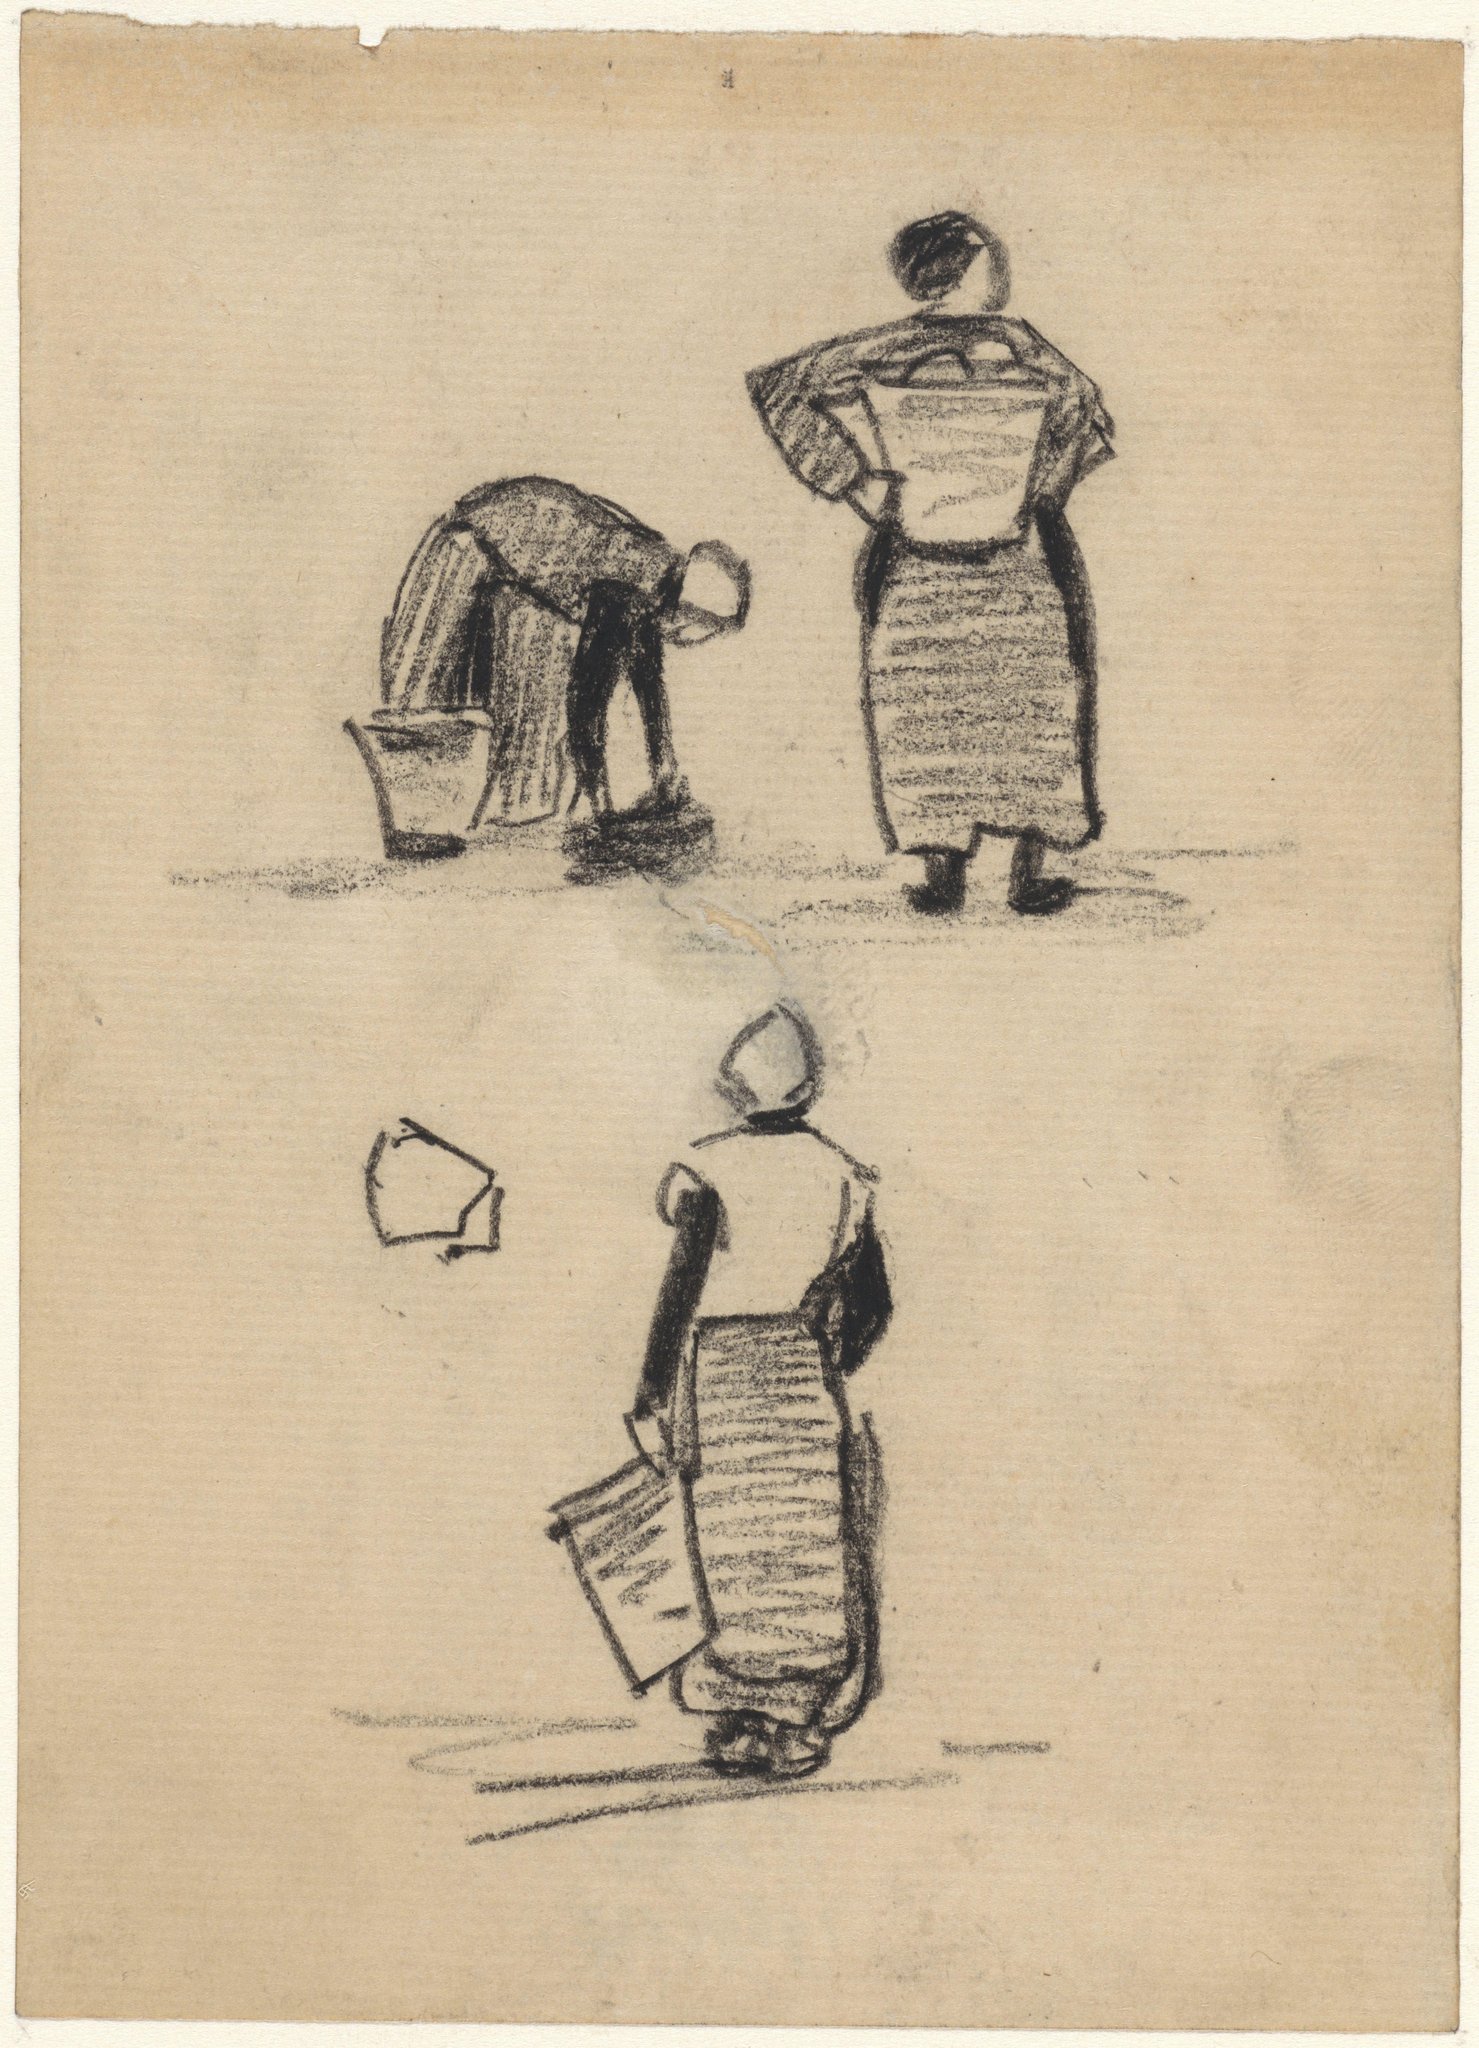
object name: drawing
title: Studies van een vrouw met een mand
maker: theo nieuwenhuis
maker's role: designer, draughtsman, print maker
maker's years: 1866-1951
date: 1876-1951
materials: chalk, paper